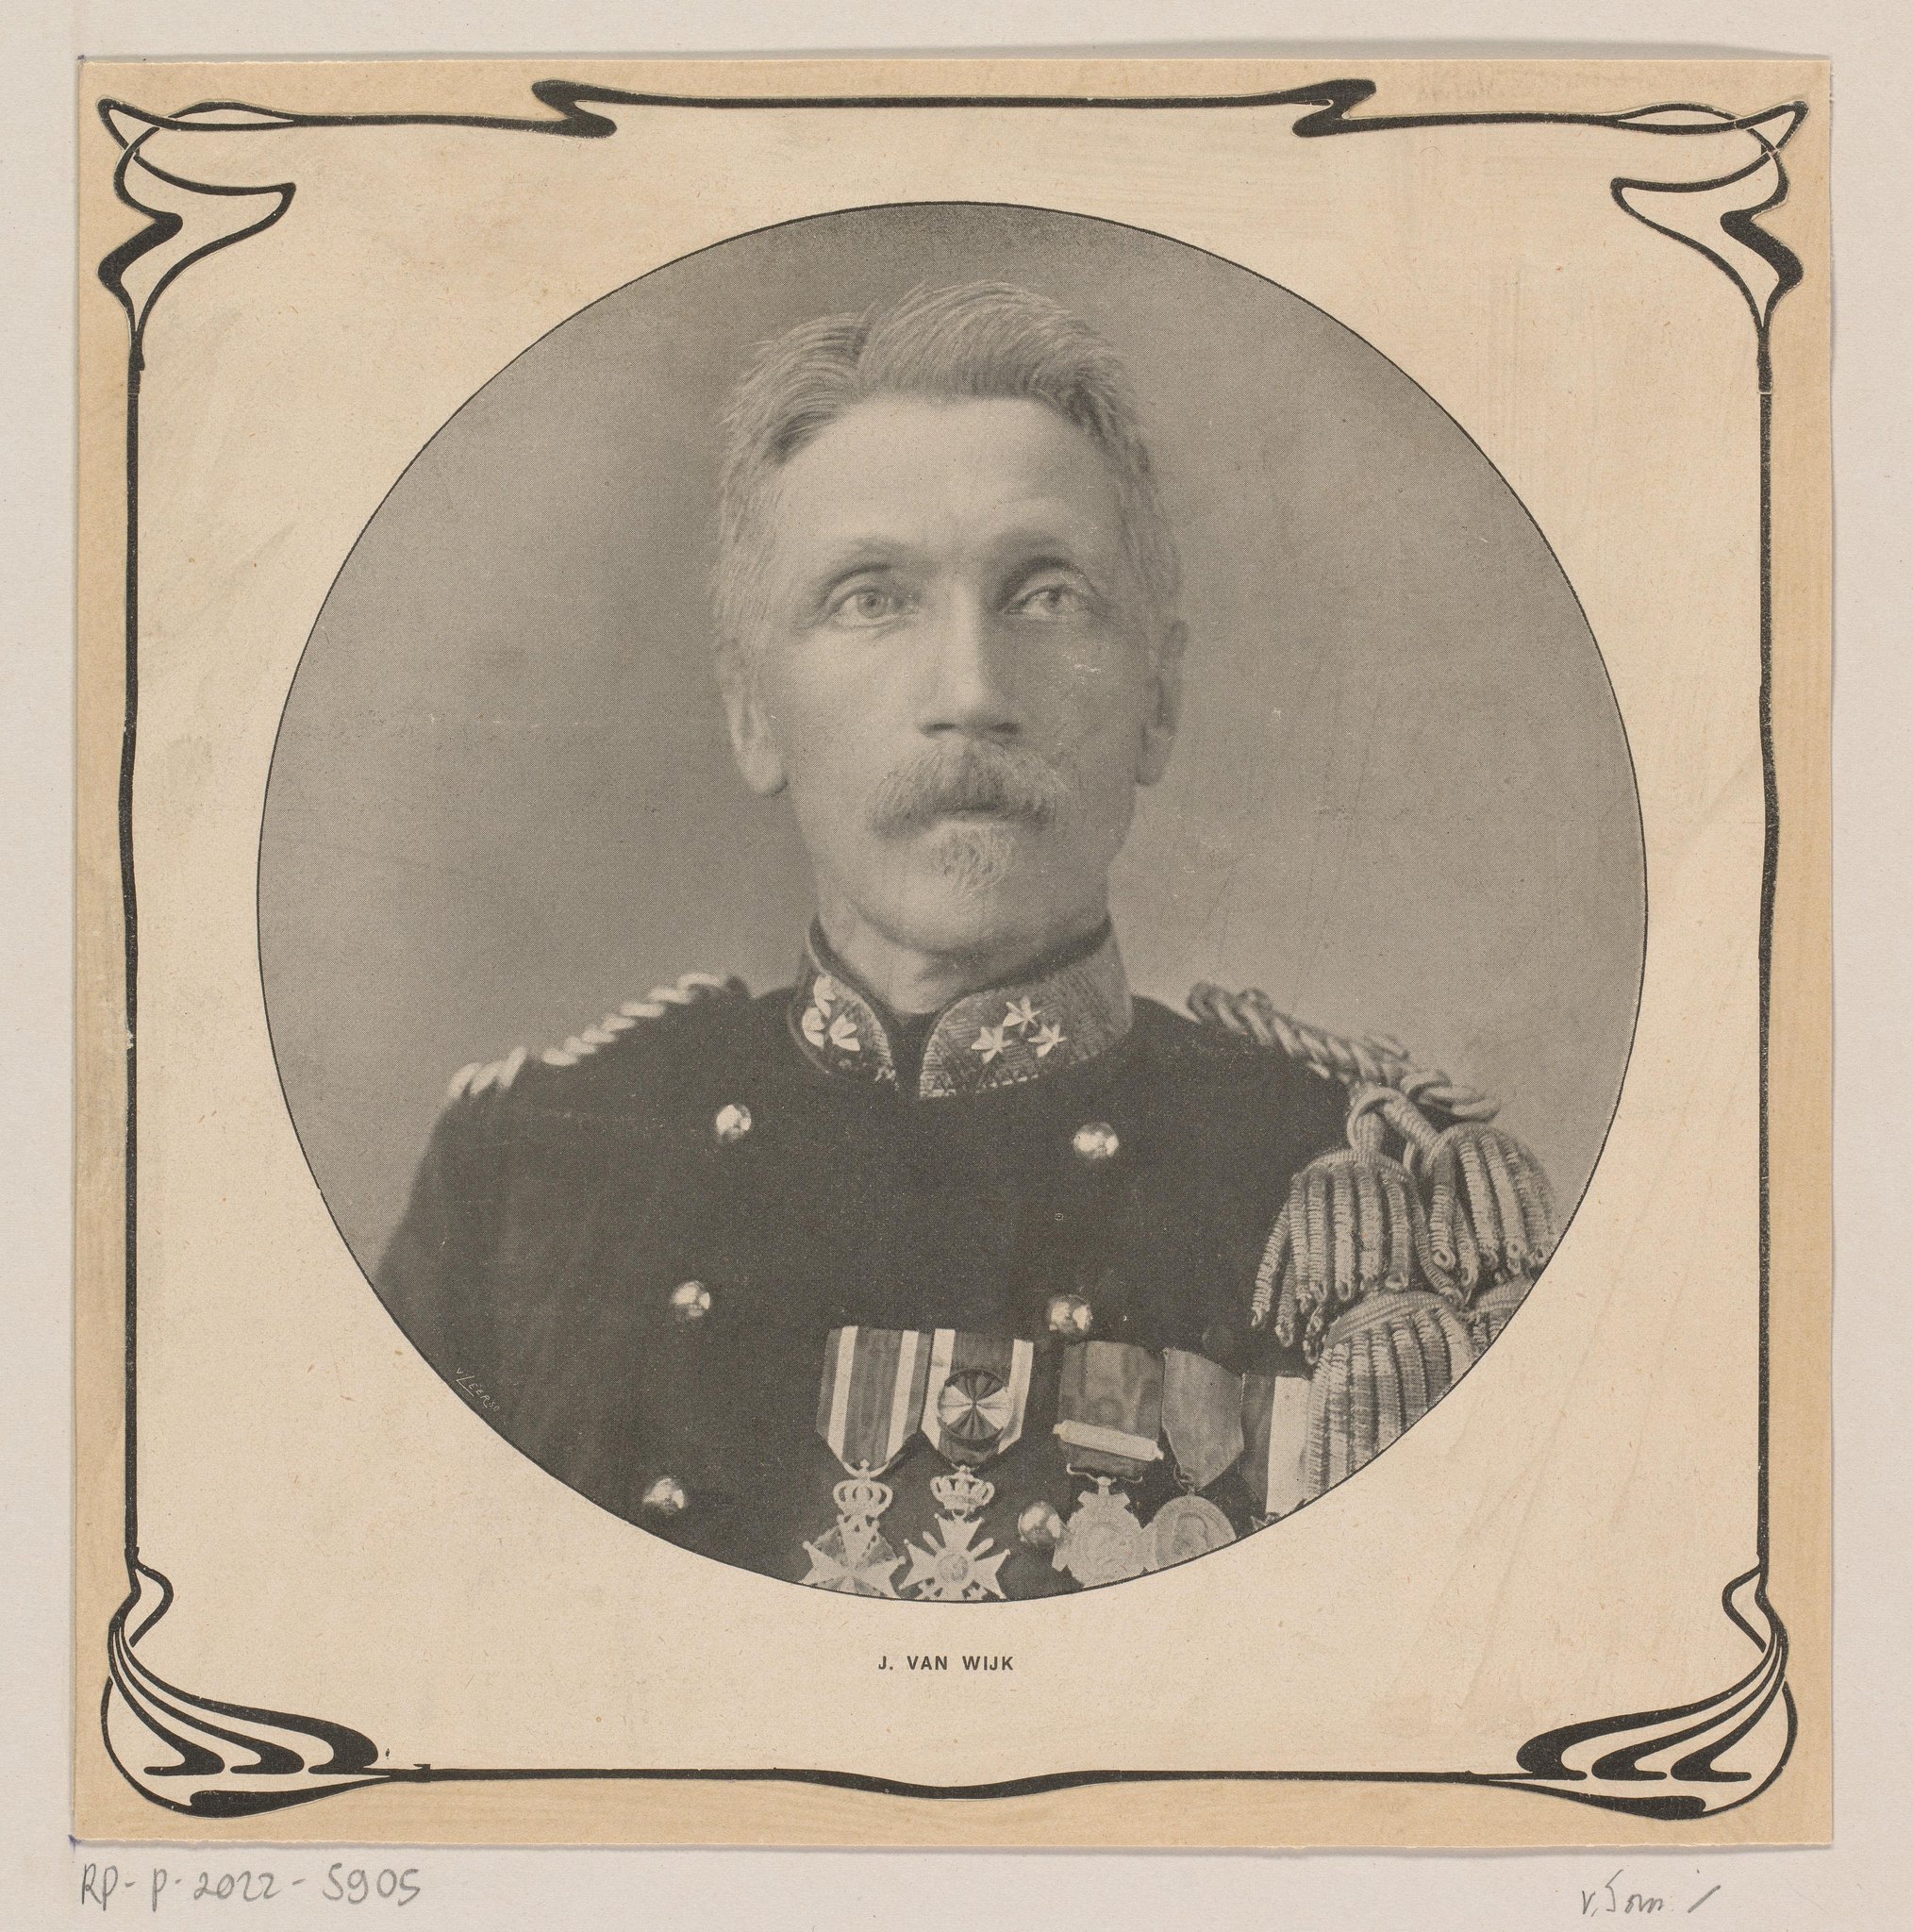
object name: photomechanical print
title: Portret van Johan Cornelis van der Wijck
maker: Anonymous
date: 1907-1919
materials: paper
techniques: autotype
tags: the hague, historical persons, lawyer, attorney at law